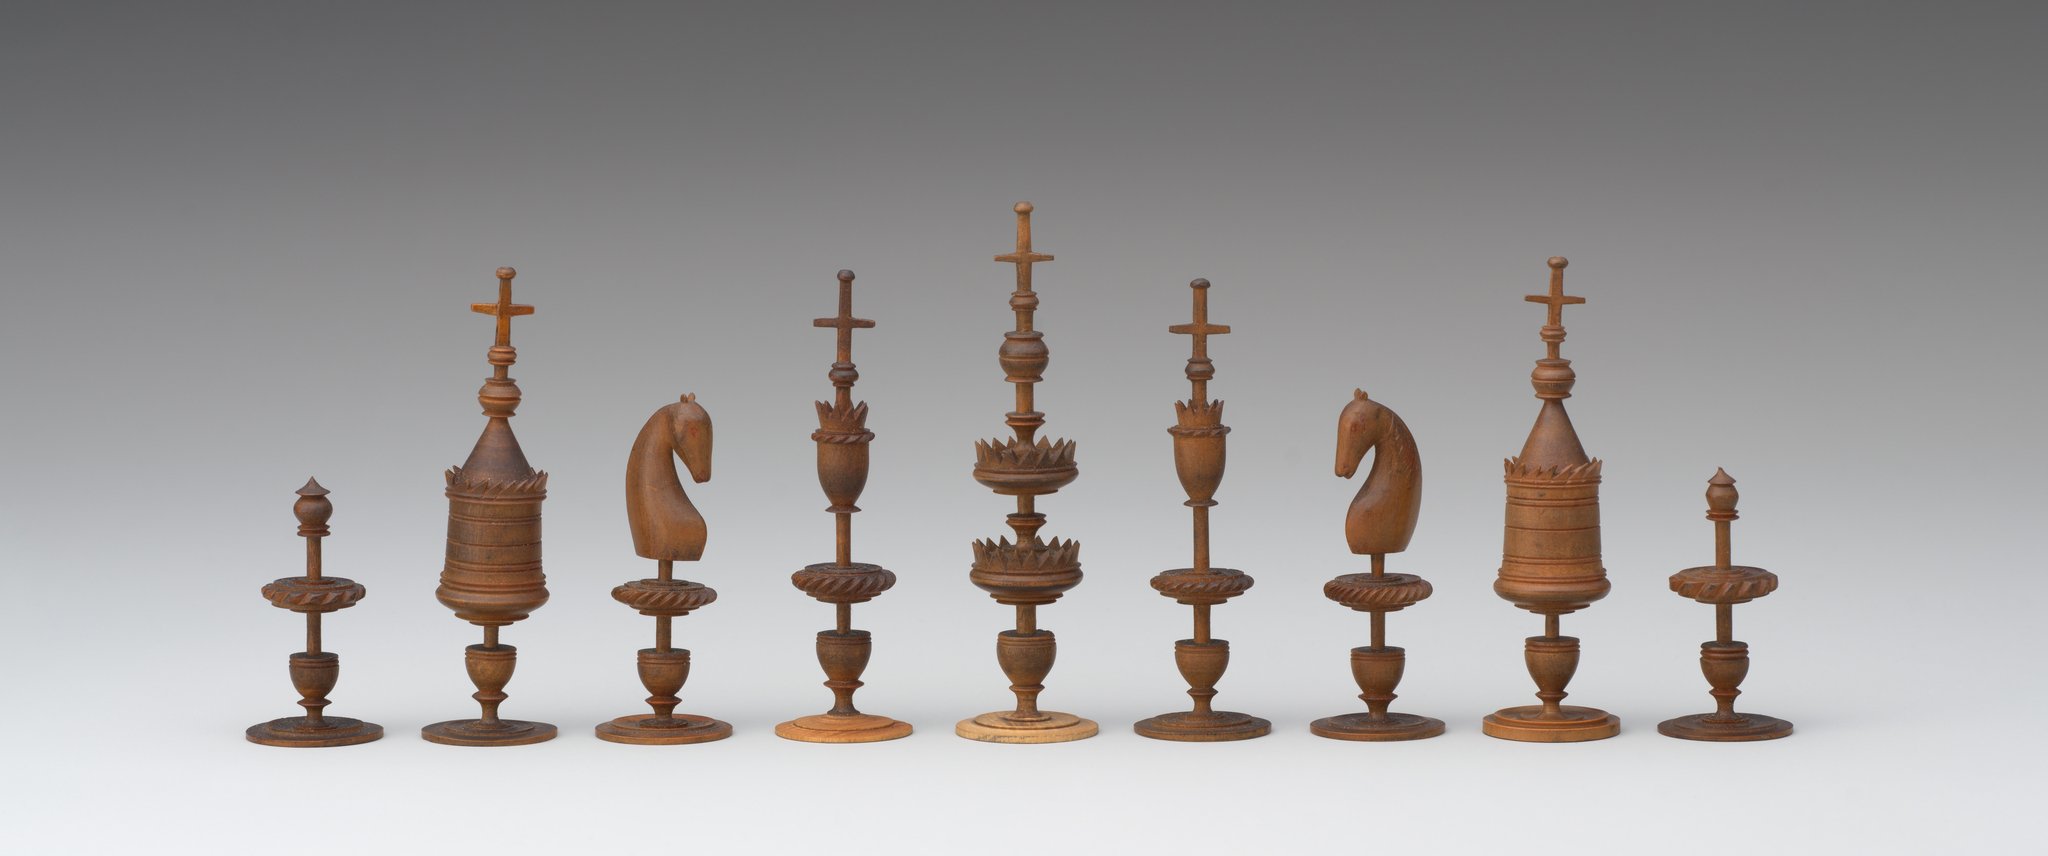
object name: chessman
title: Chessmen (28)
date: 1801-1900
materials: wood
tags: chess